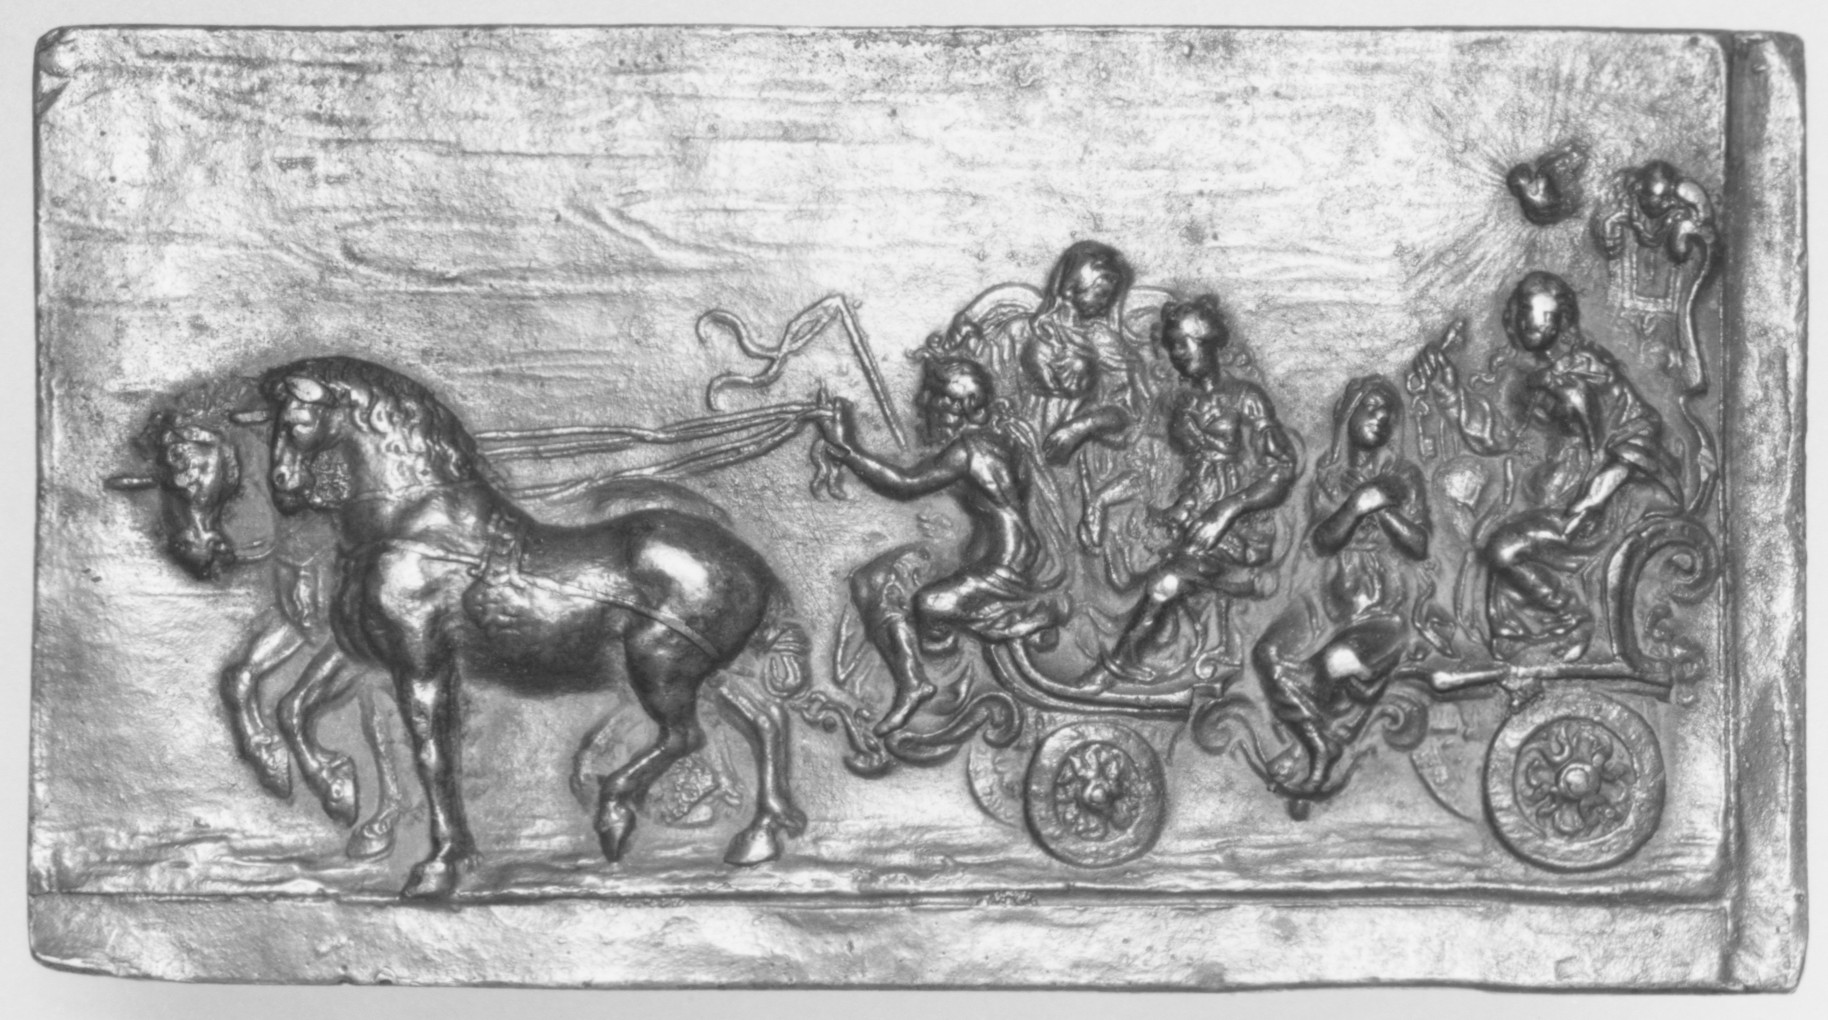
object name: plaquette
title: The Triumph of the Church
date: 1576-1600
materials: lead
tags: men,women,horses,chariots